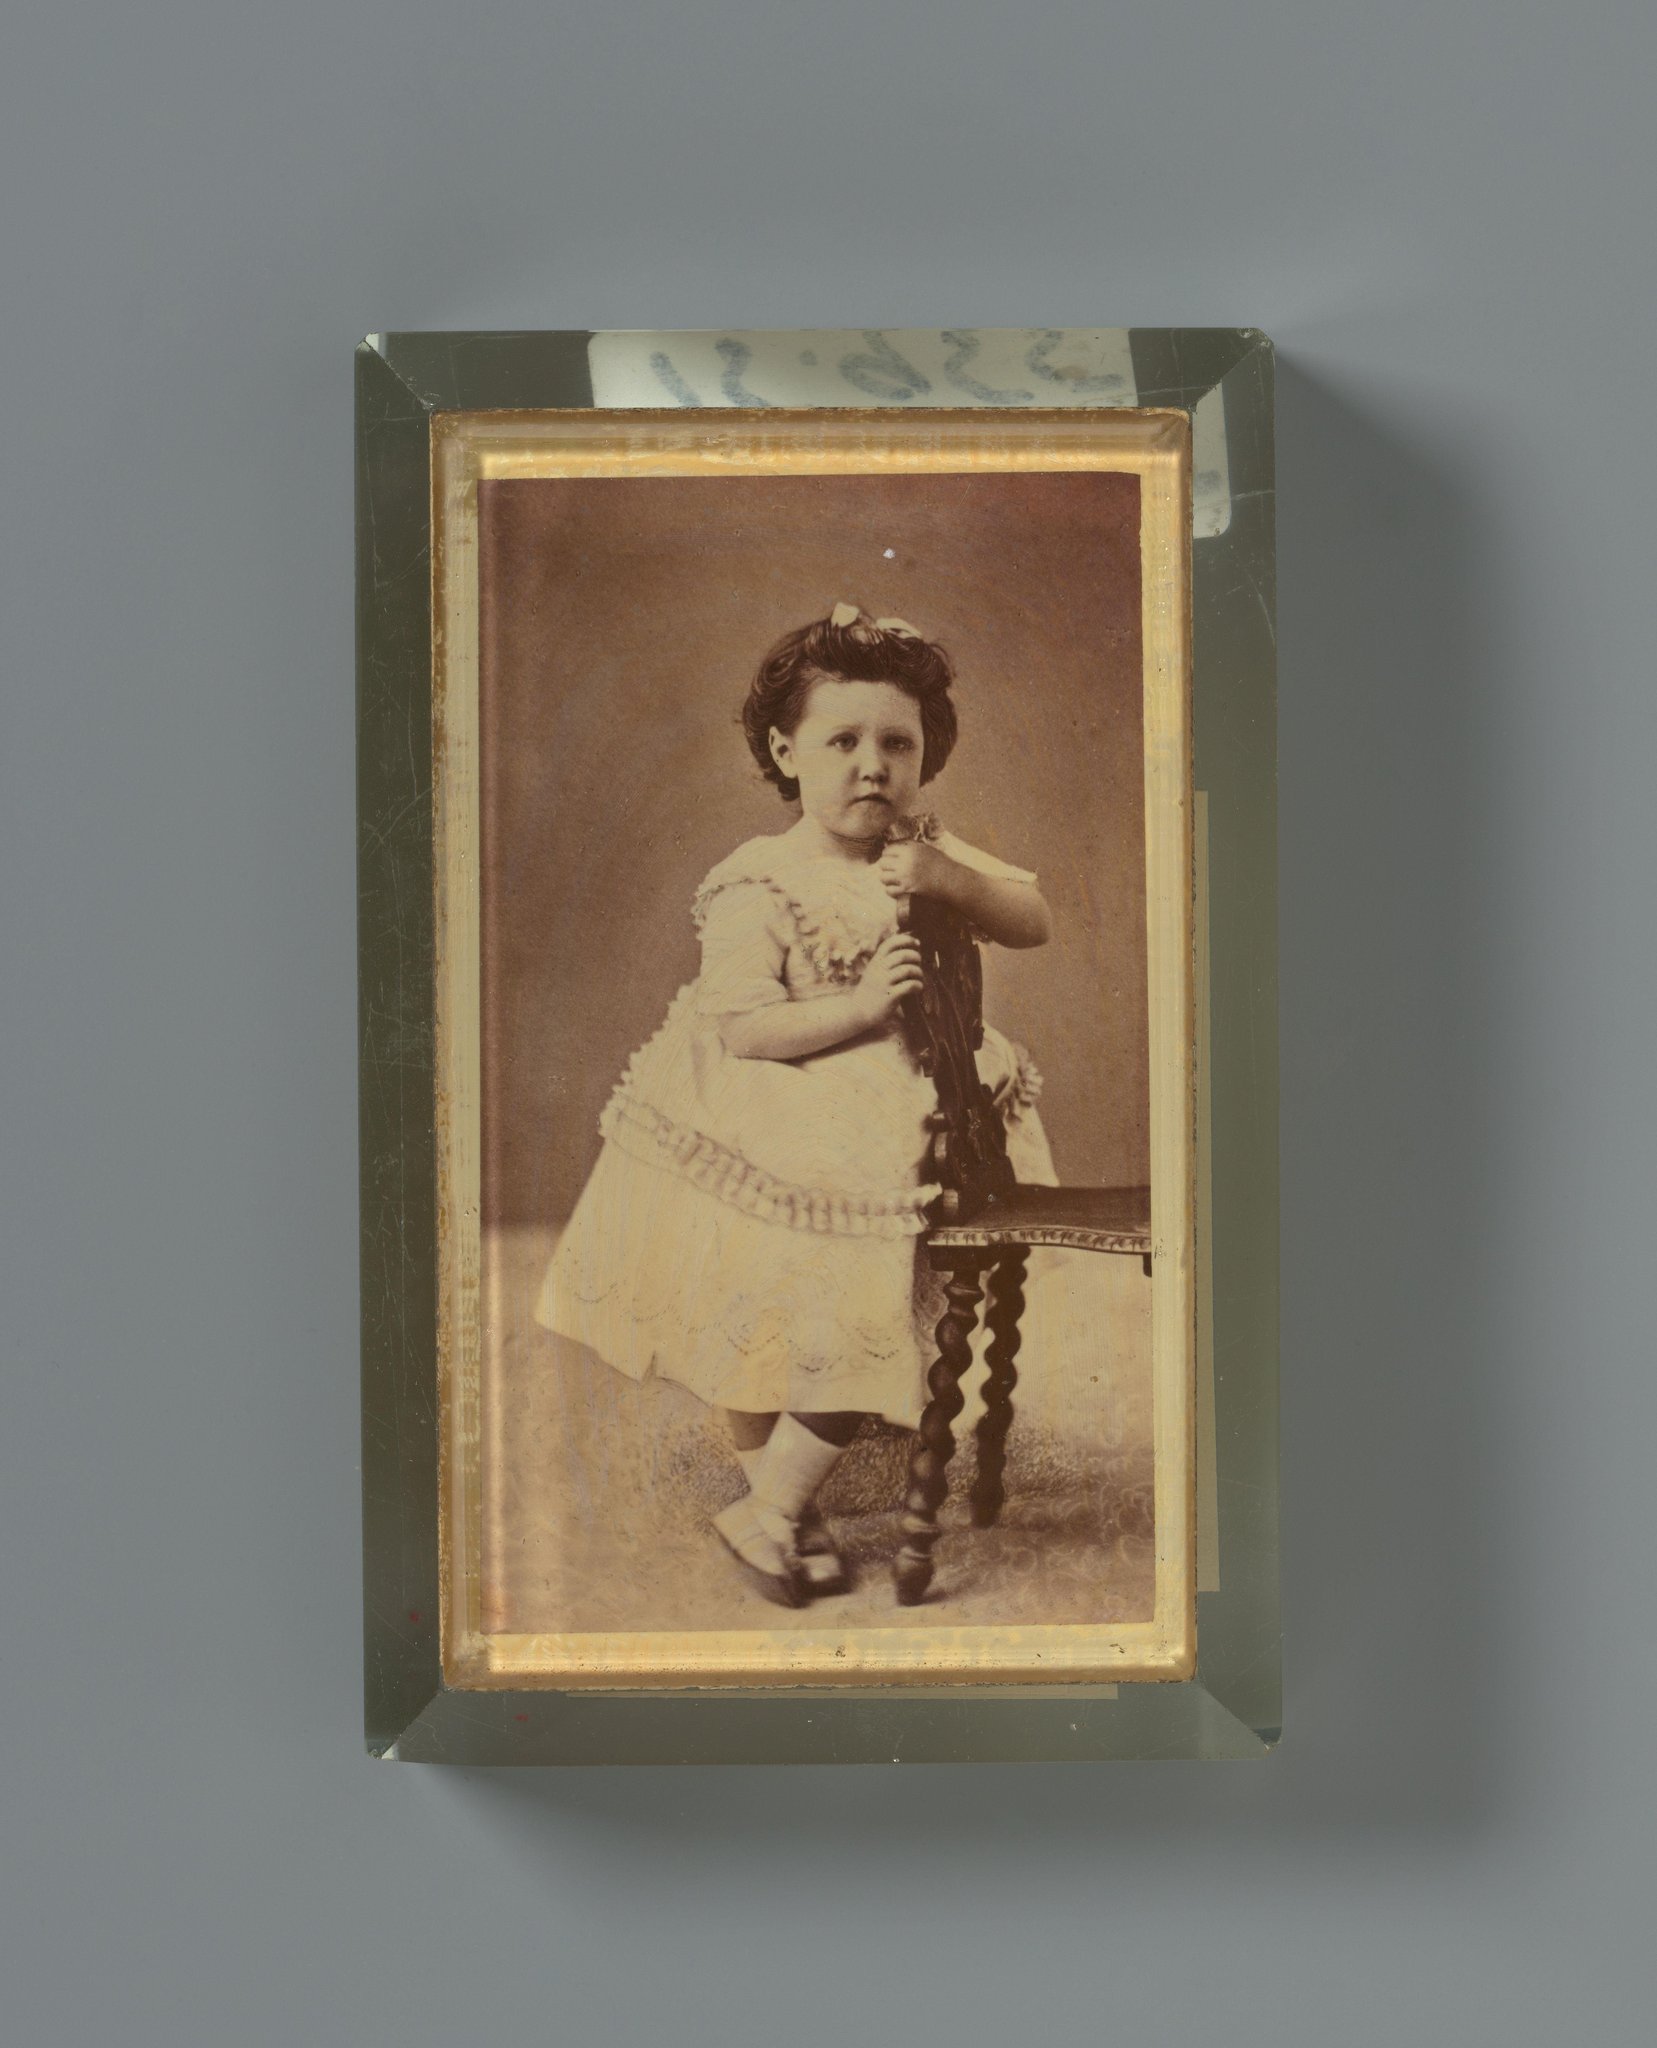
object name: paperweight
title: Presse-papier met een portret van een onbekend meisje leunend tegen een stoel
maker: Anonymous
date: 1870-1900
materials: glass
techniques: albumen print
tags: historical persons not known by name - bb - woman, girl (child between toddler and youth)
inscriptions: inscription: ‘albumine (repro?)’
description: Rechthoekige glazen presse-papier met een portret van een onbekend meisje leunend tegen een stoel.